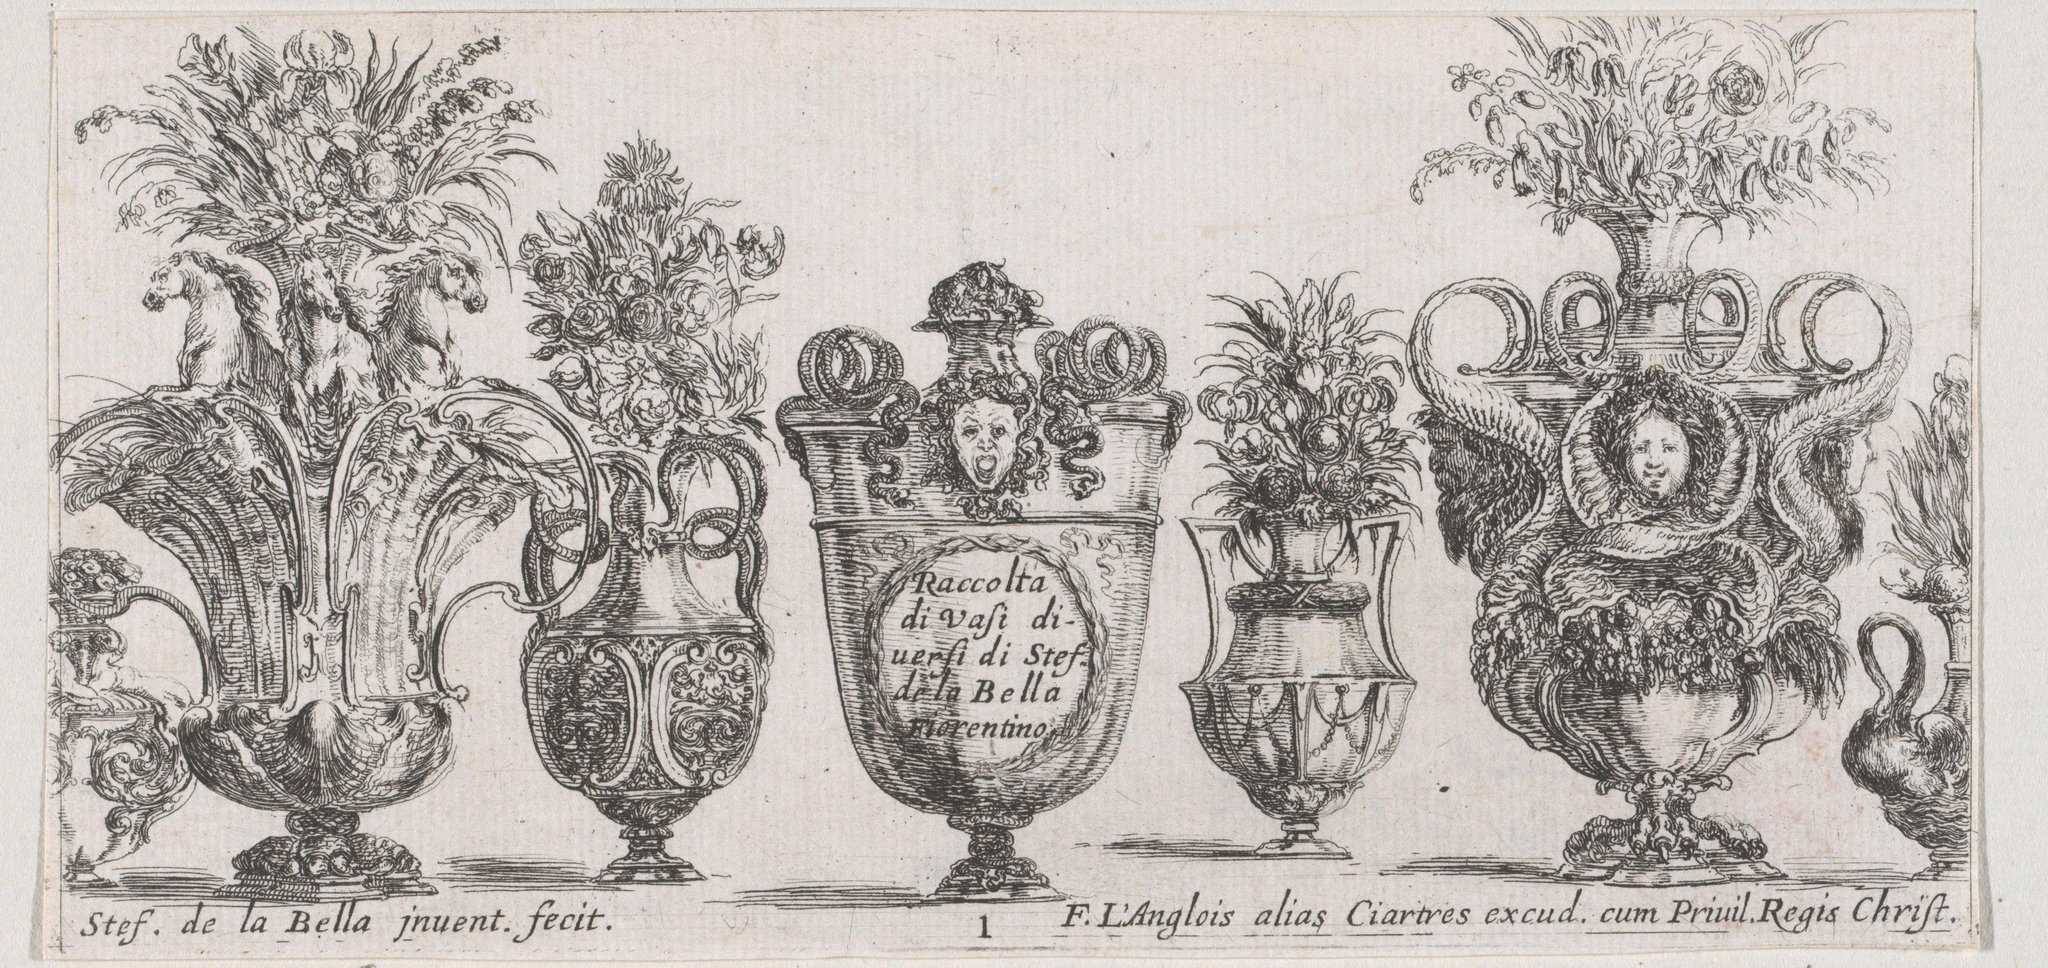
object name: titelprent, frontispice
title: Titelprent met zeven vazen op een rij, de middelste met Medusahoofd en titel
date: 1620-1664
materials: paper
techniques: etching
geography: paris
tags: vase ~ ornament, garden vase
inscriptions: collector's mark: Lugt 240